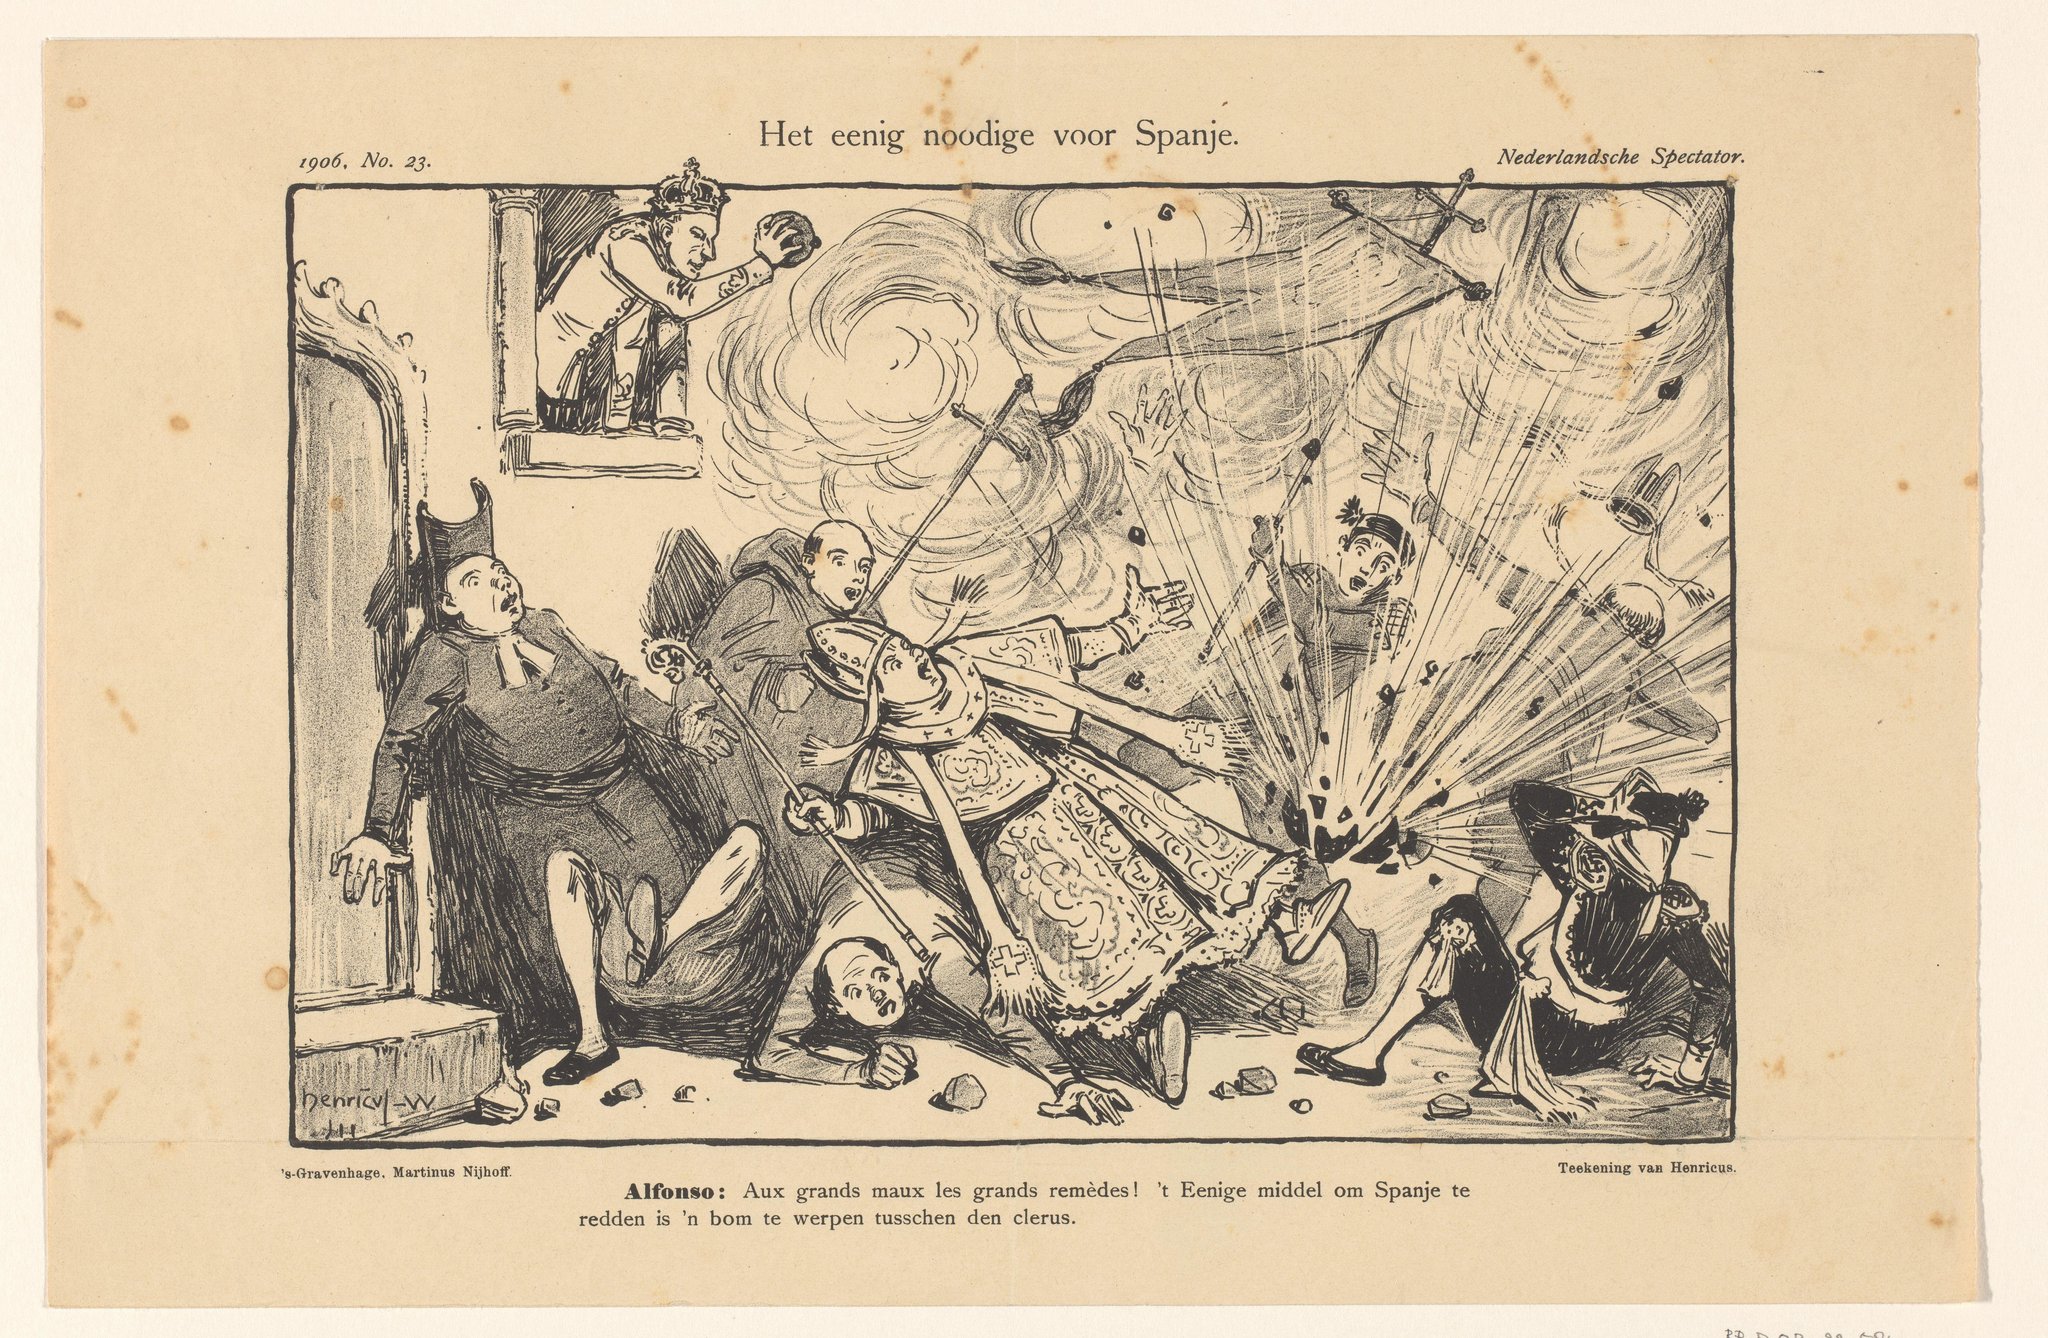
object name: cartoon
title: Het eenig noodige voor Spanje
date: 1906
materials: paper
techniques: lithograph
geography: the hague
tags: violent death by bomb, hand-grenade, organization, functionaries and dignitaries in roman catholic church; clergy in general, political caricatures and satires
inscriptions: collector's mark: Lugt 2228a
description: Een bom ontploft te midden van verschillende vertegenwoordigers van de katholieke geestelijkheid.